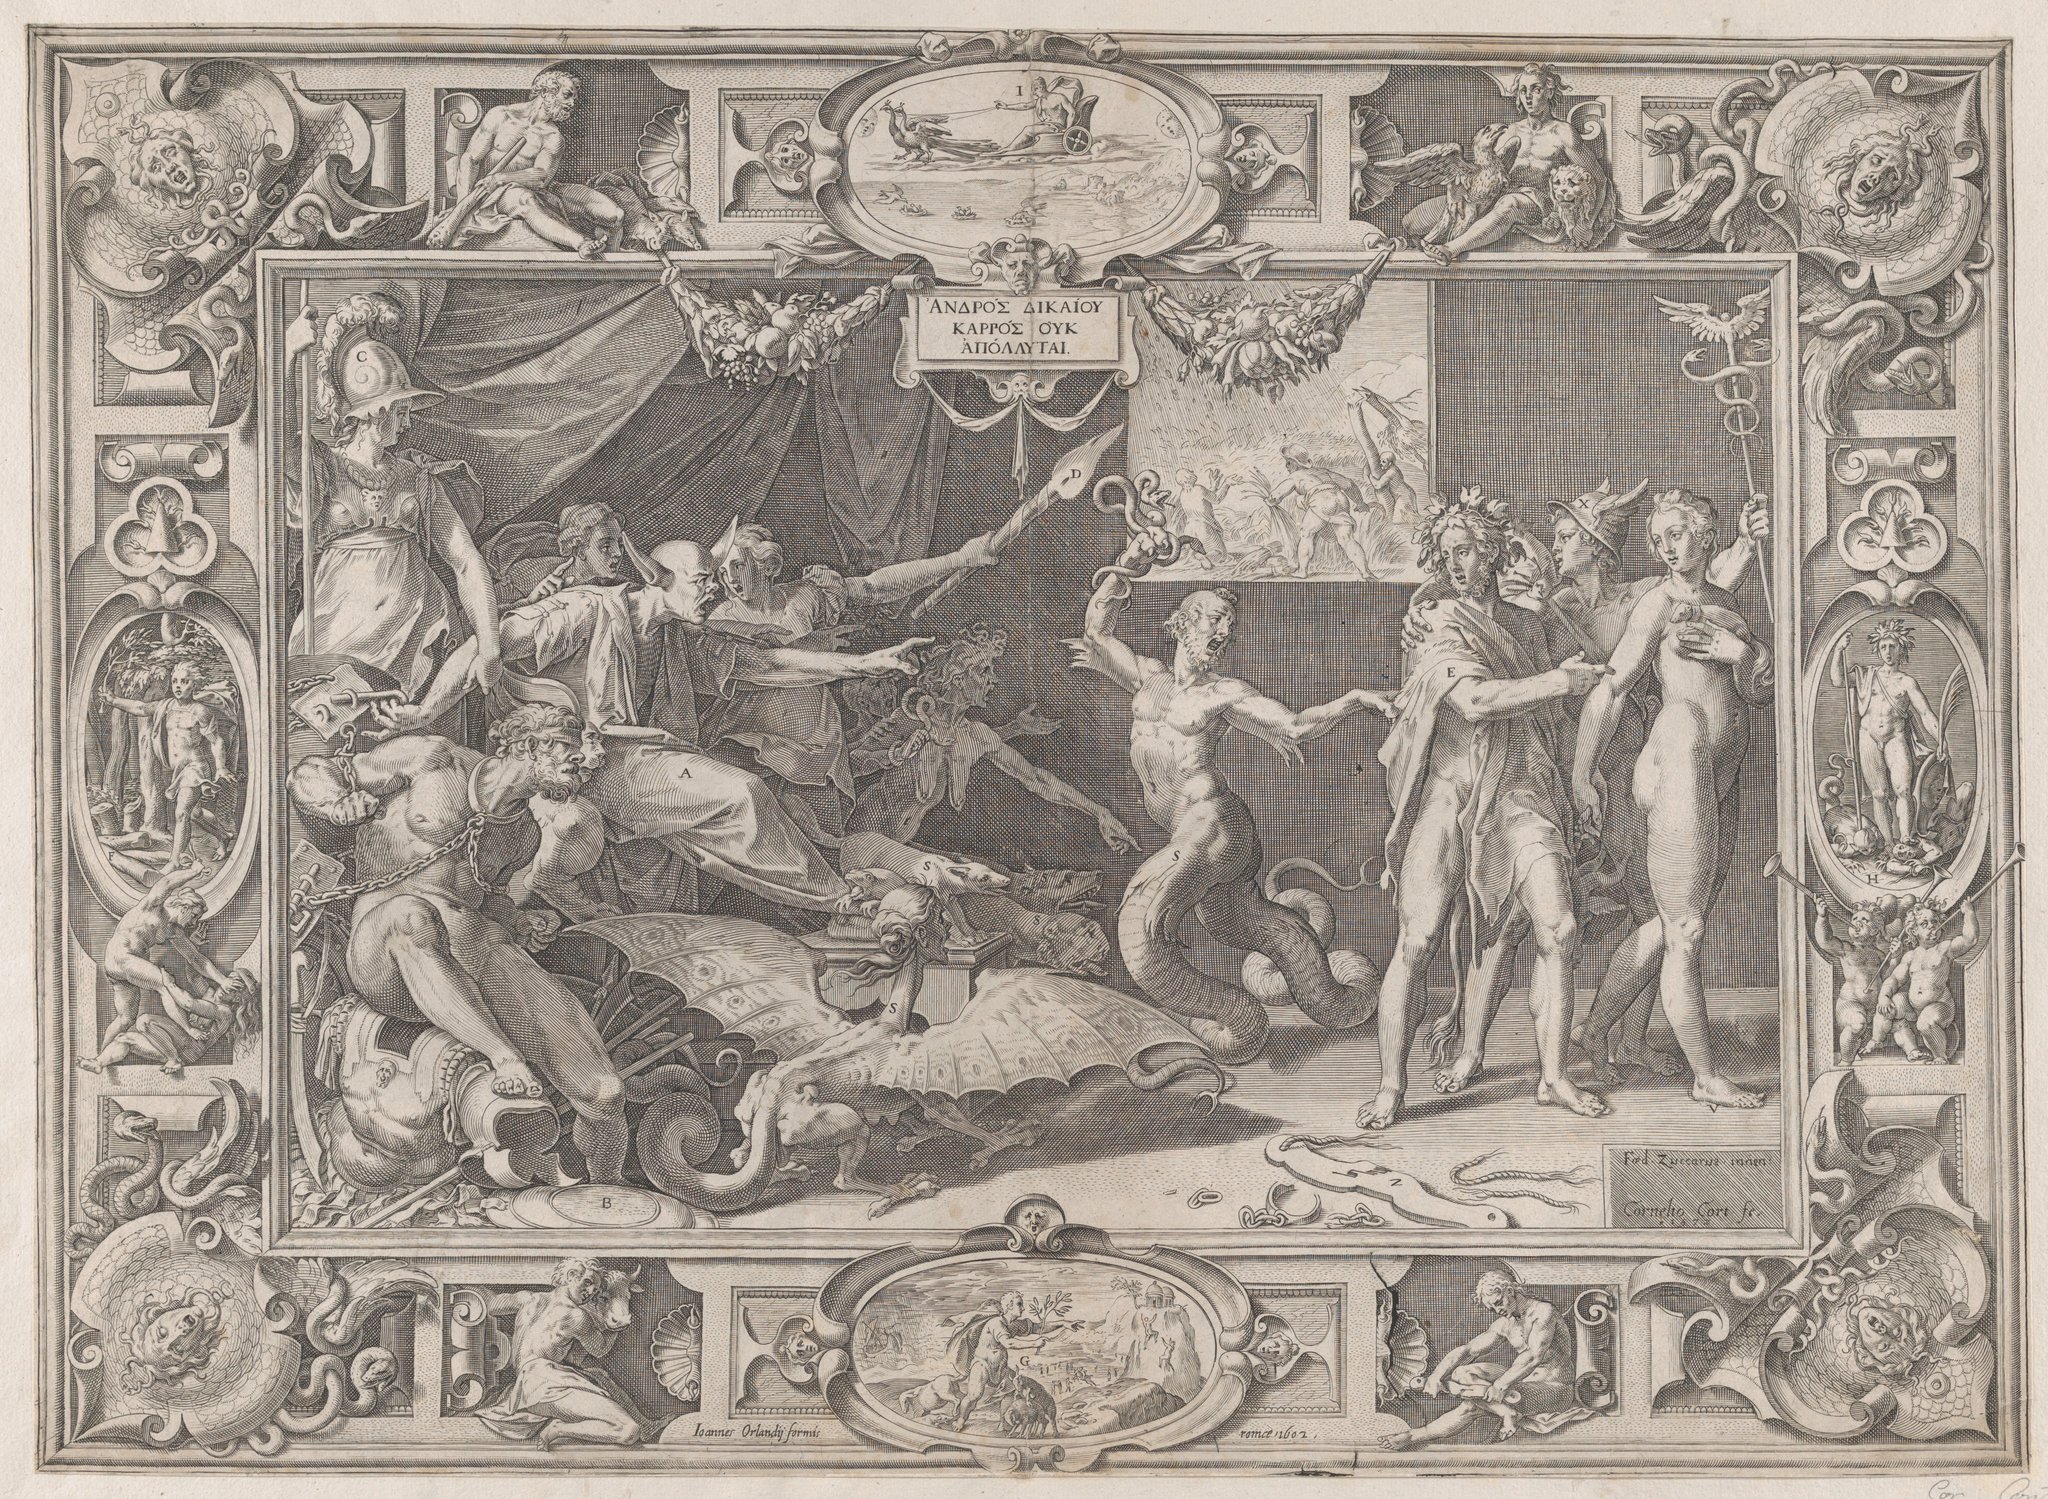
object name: print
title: The Calumny of Apelles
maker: cornelis cort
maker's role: artist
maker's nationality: netherlandish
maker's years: 1533-1578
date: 1602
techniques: engraving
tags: faces,male nudes,female nudes,punishment